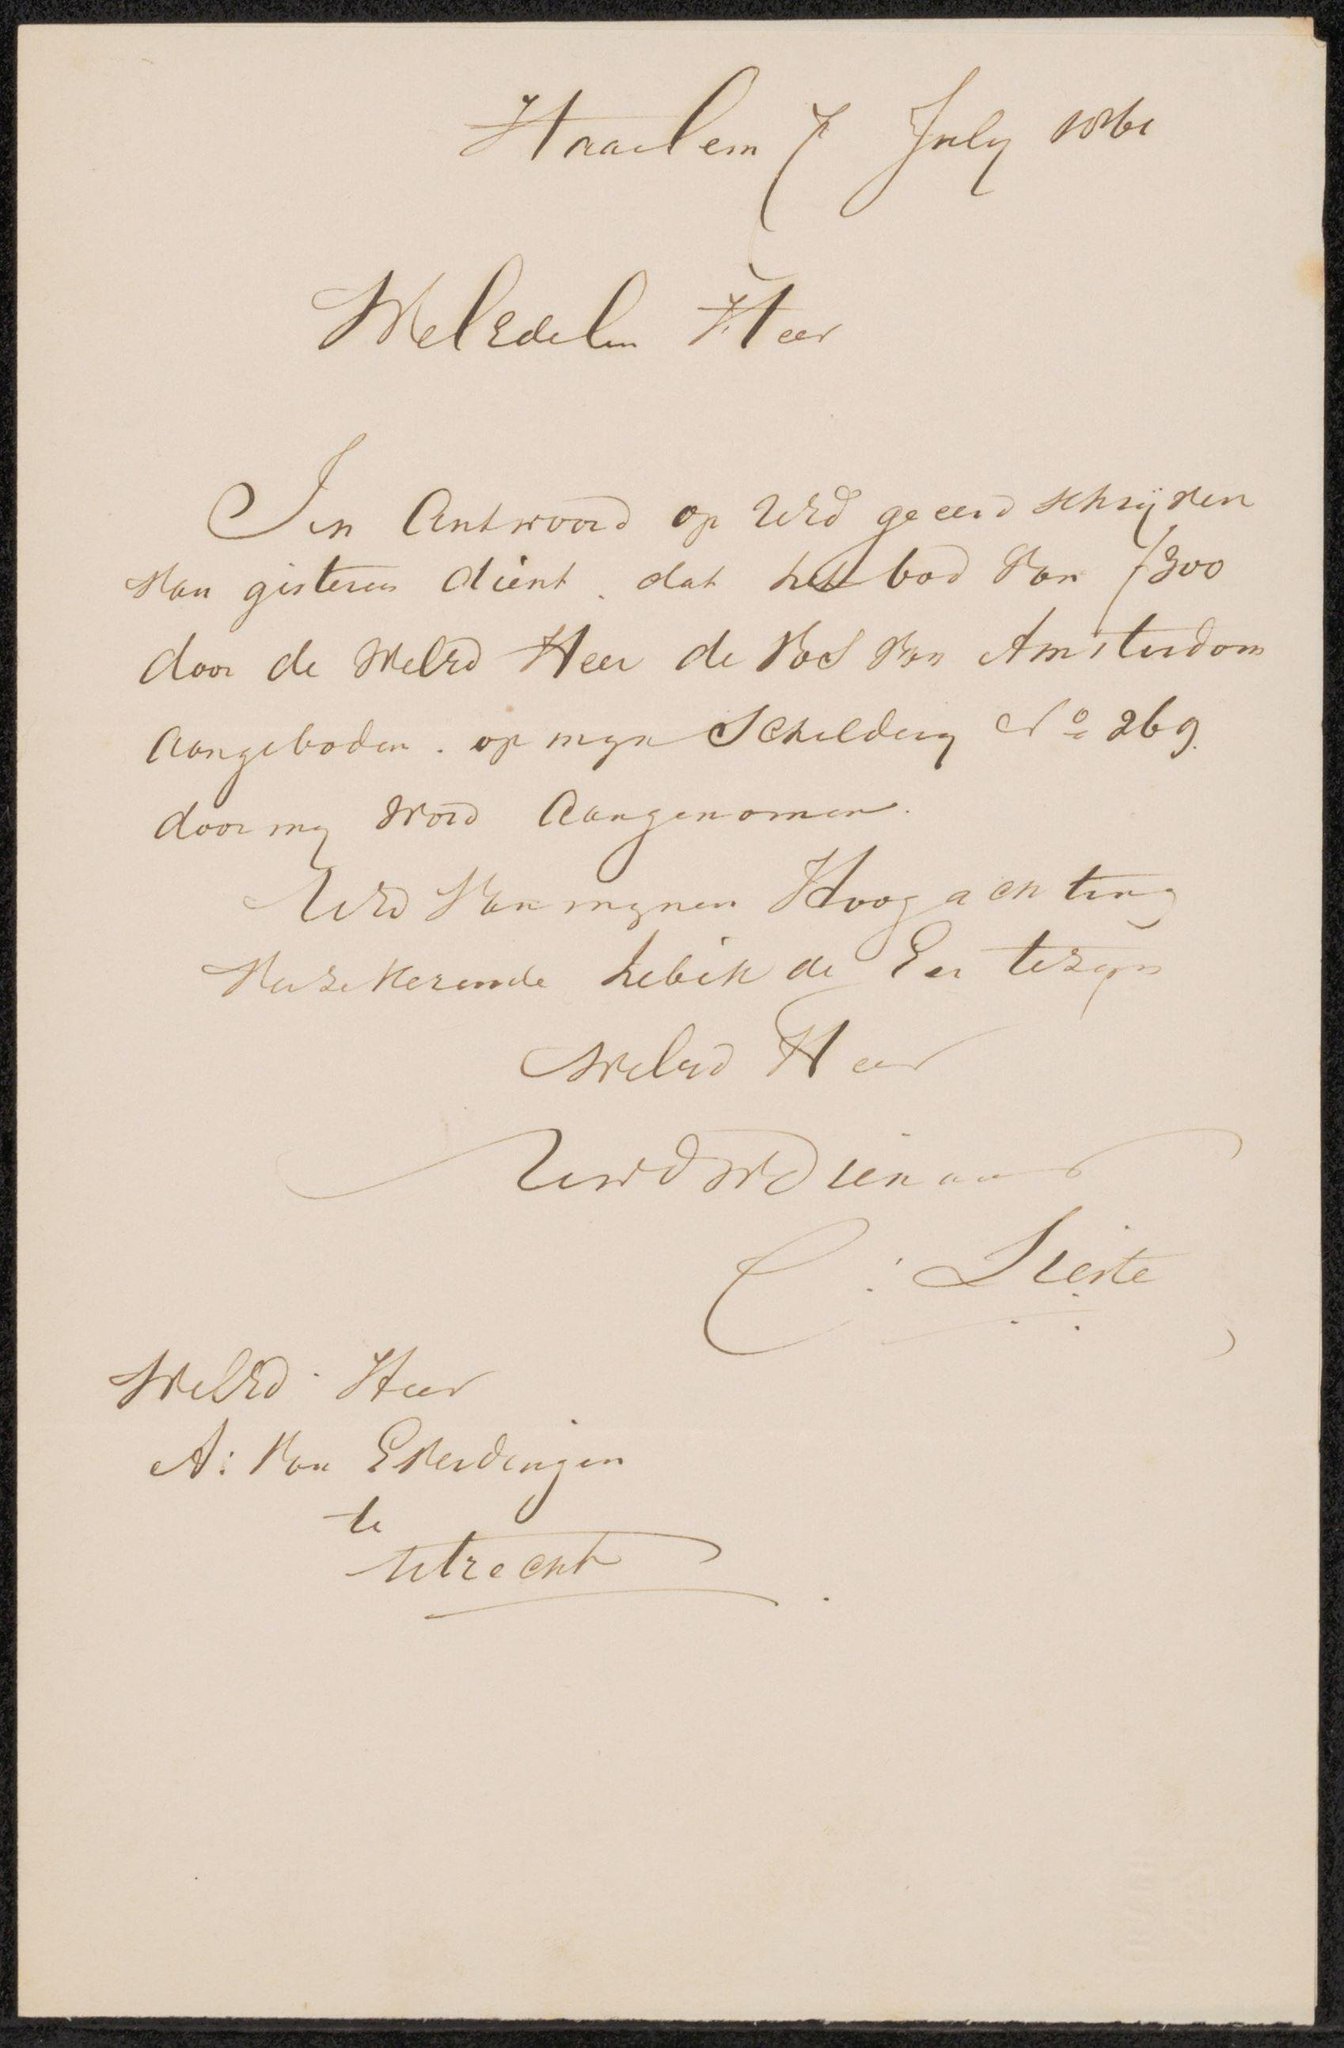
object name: letter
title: Brief aan Adrianus van Everdingen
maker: cornelis lieste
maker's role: draughtsman, print maker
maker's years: 1817-1861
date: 1861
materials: ink, paper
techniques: pen, writing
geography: haarlem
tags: utrecht, print maker, adrianus van everdingen, amsterdam, jacob jacobsz. de vos (1803-1878), art trade, art shop, painting (including book-illumination, miniature-painting), money